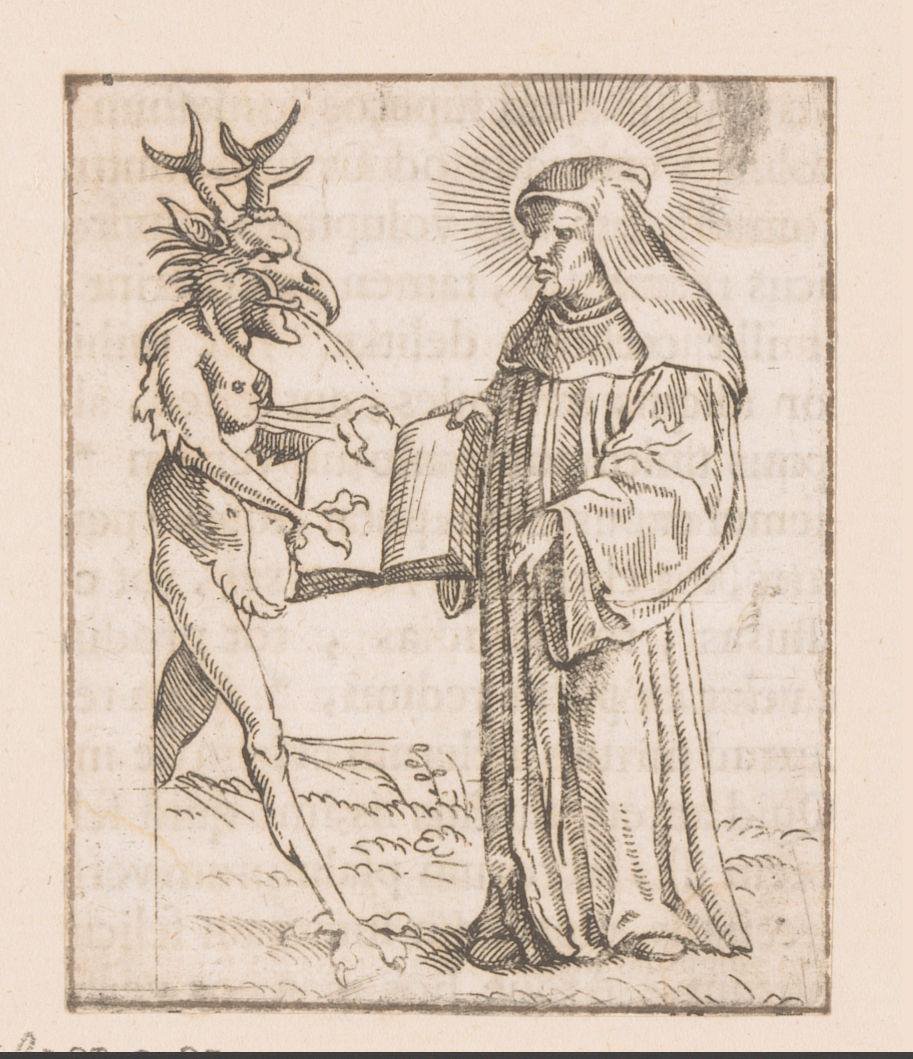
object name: print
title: Duivel wijst de heilige Bernardus op de psalmen in de bijbel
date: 1516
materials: paper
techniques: etching, letterpress printing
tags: rotterdam, desiderius erasmus, bernard of clairvaux, cistercian monk and abbot; possible attributes: beehive, chained dragon, crucifix, cross with instruments of the passion, (three) mitre at his feet, white dog, bible (+ devil(s))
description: Prent afkomstig uit: Erasmus, Desiderius. Morias enkomion (...). Bazel: Johann Rudolf Genath, 1676. De prenten hierin zijn naar tekeningen die Hans en Ambrosius Holbein maakten voor de theoloog Oswald Myconius in diens uitgave van de Moriae encomium (Lof der Zotheid) van 1516.